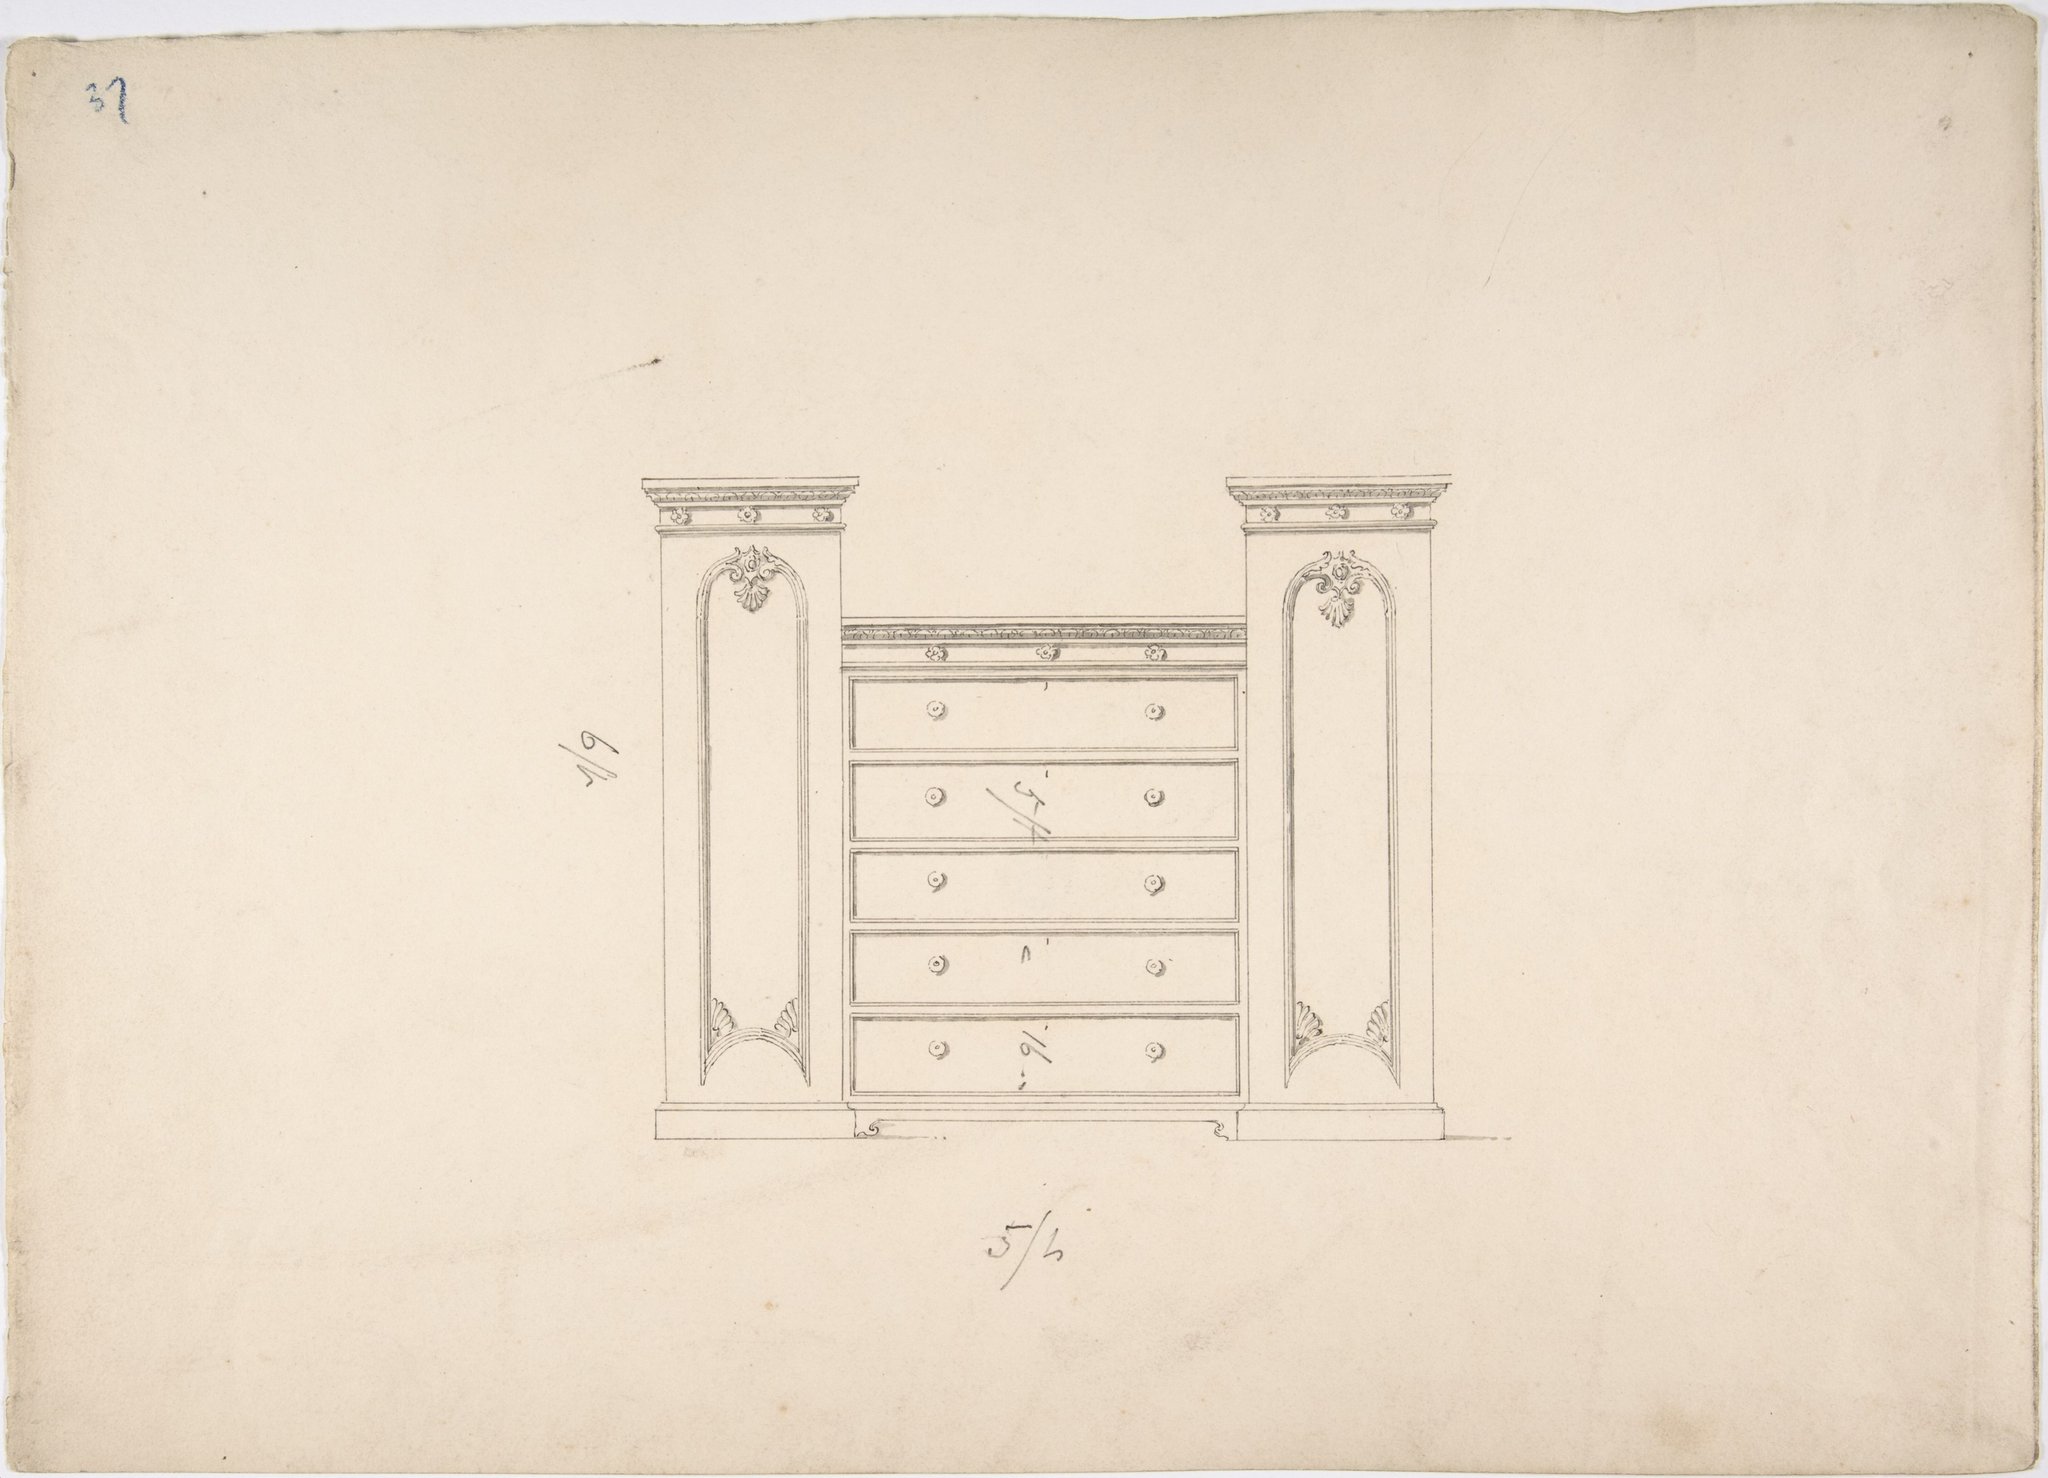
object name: drawing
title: Design for a Cabinet with Central Drawers and Palmeate Ornament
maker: anonymous, british, 19th century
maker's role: artist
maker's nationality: british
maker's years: 1800-1900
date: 1801-1833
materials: ink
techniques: pen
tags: palmettes,cabinets